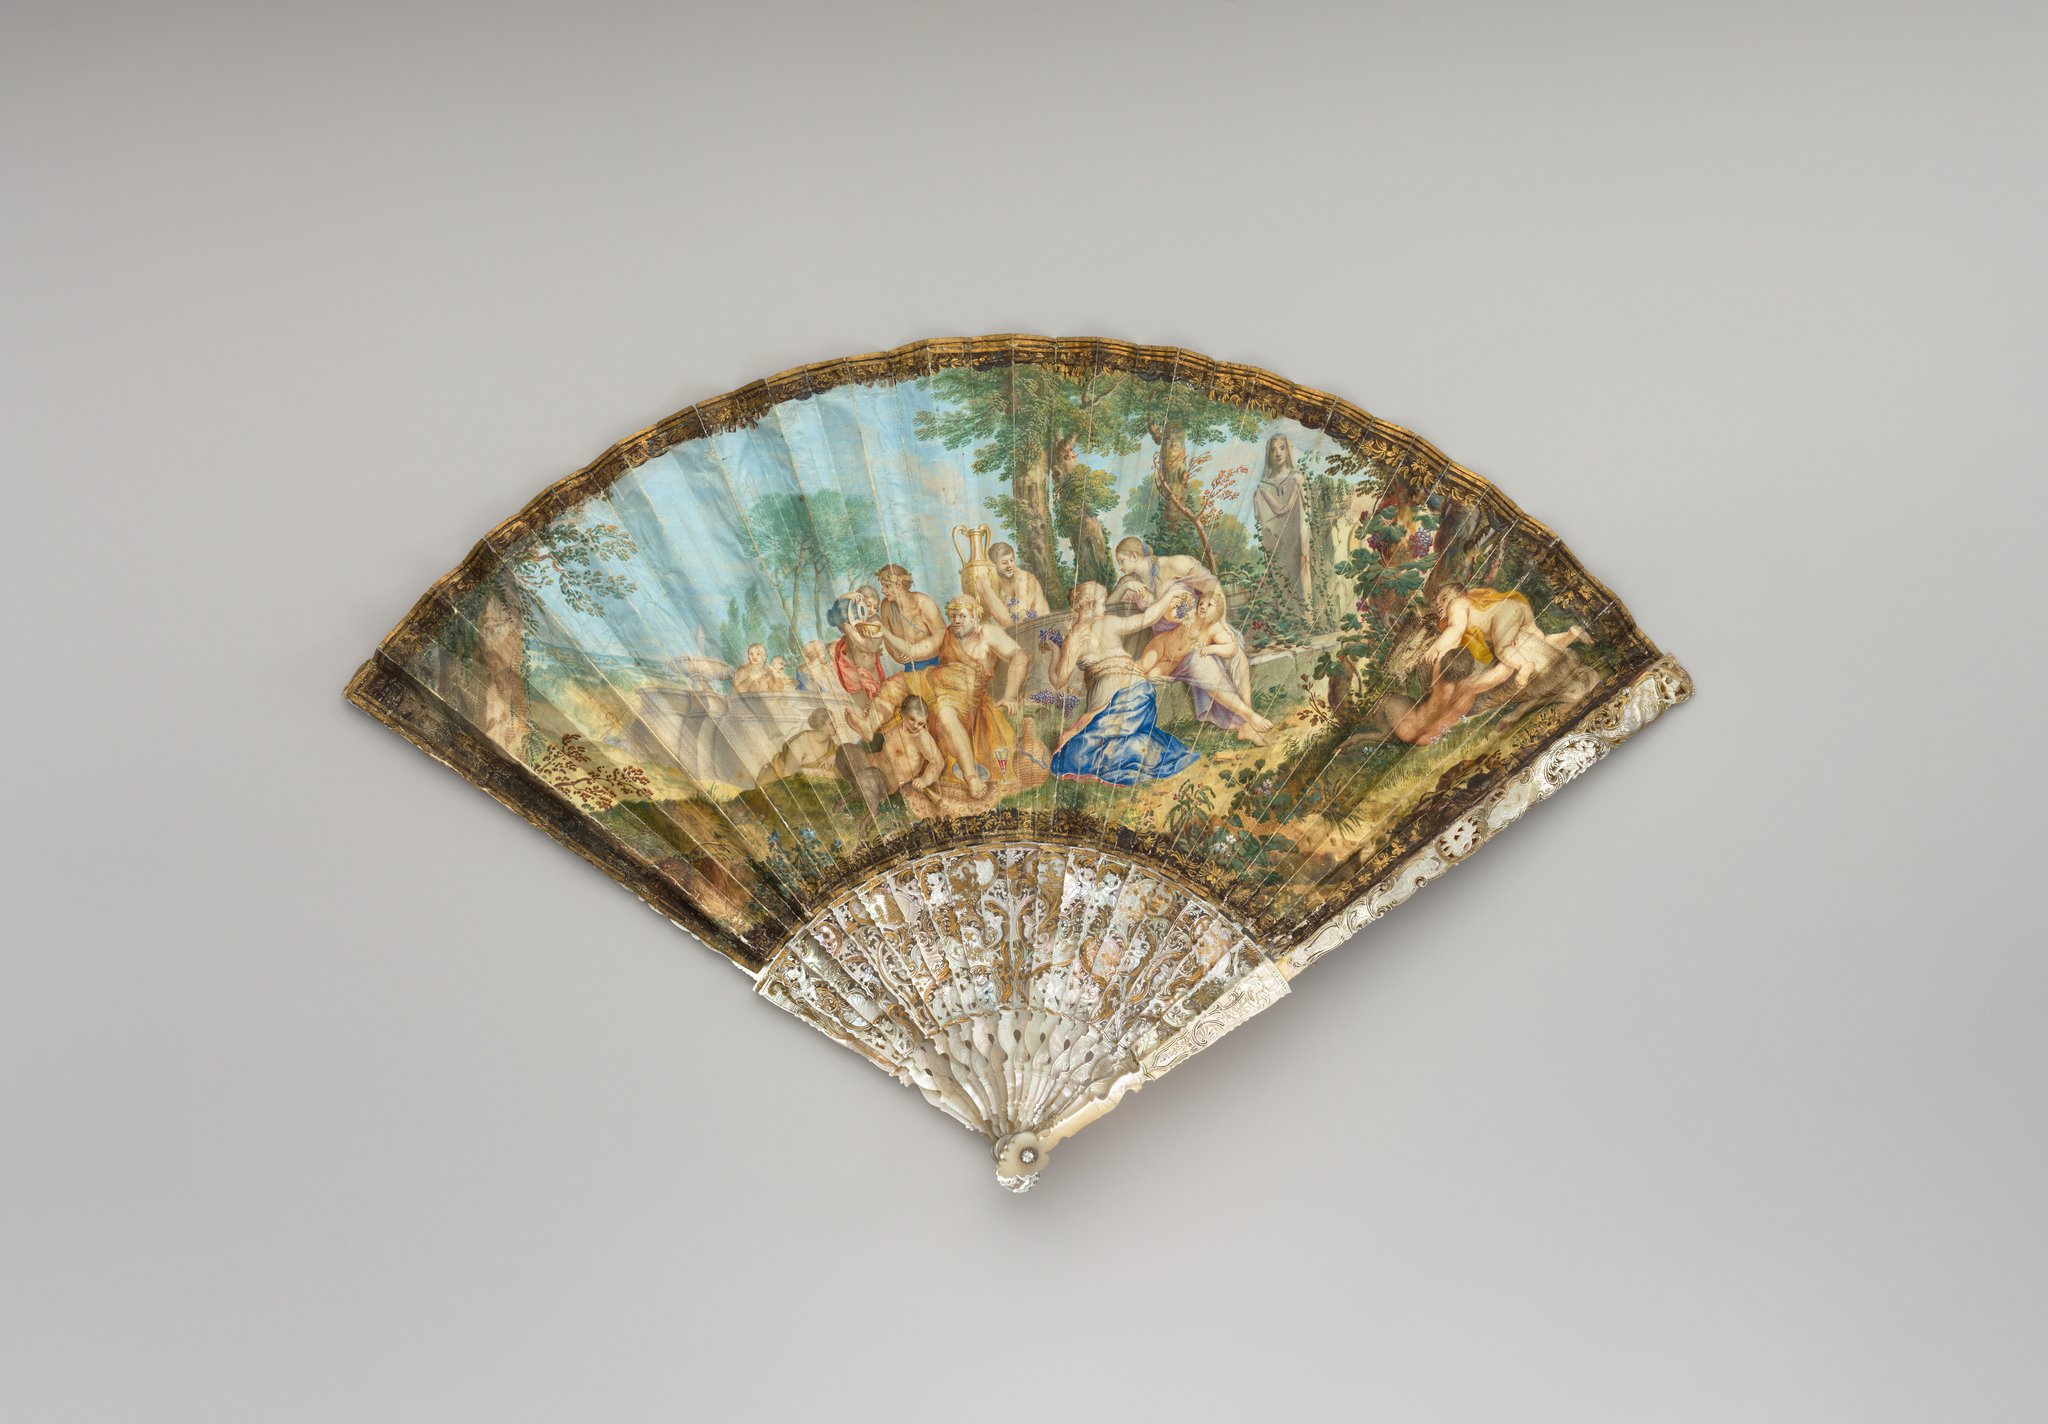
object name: fan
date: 1701-1750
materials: gilt, mother of pearl, paint, paper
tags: men,women,drinking